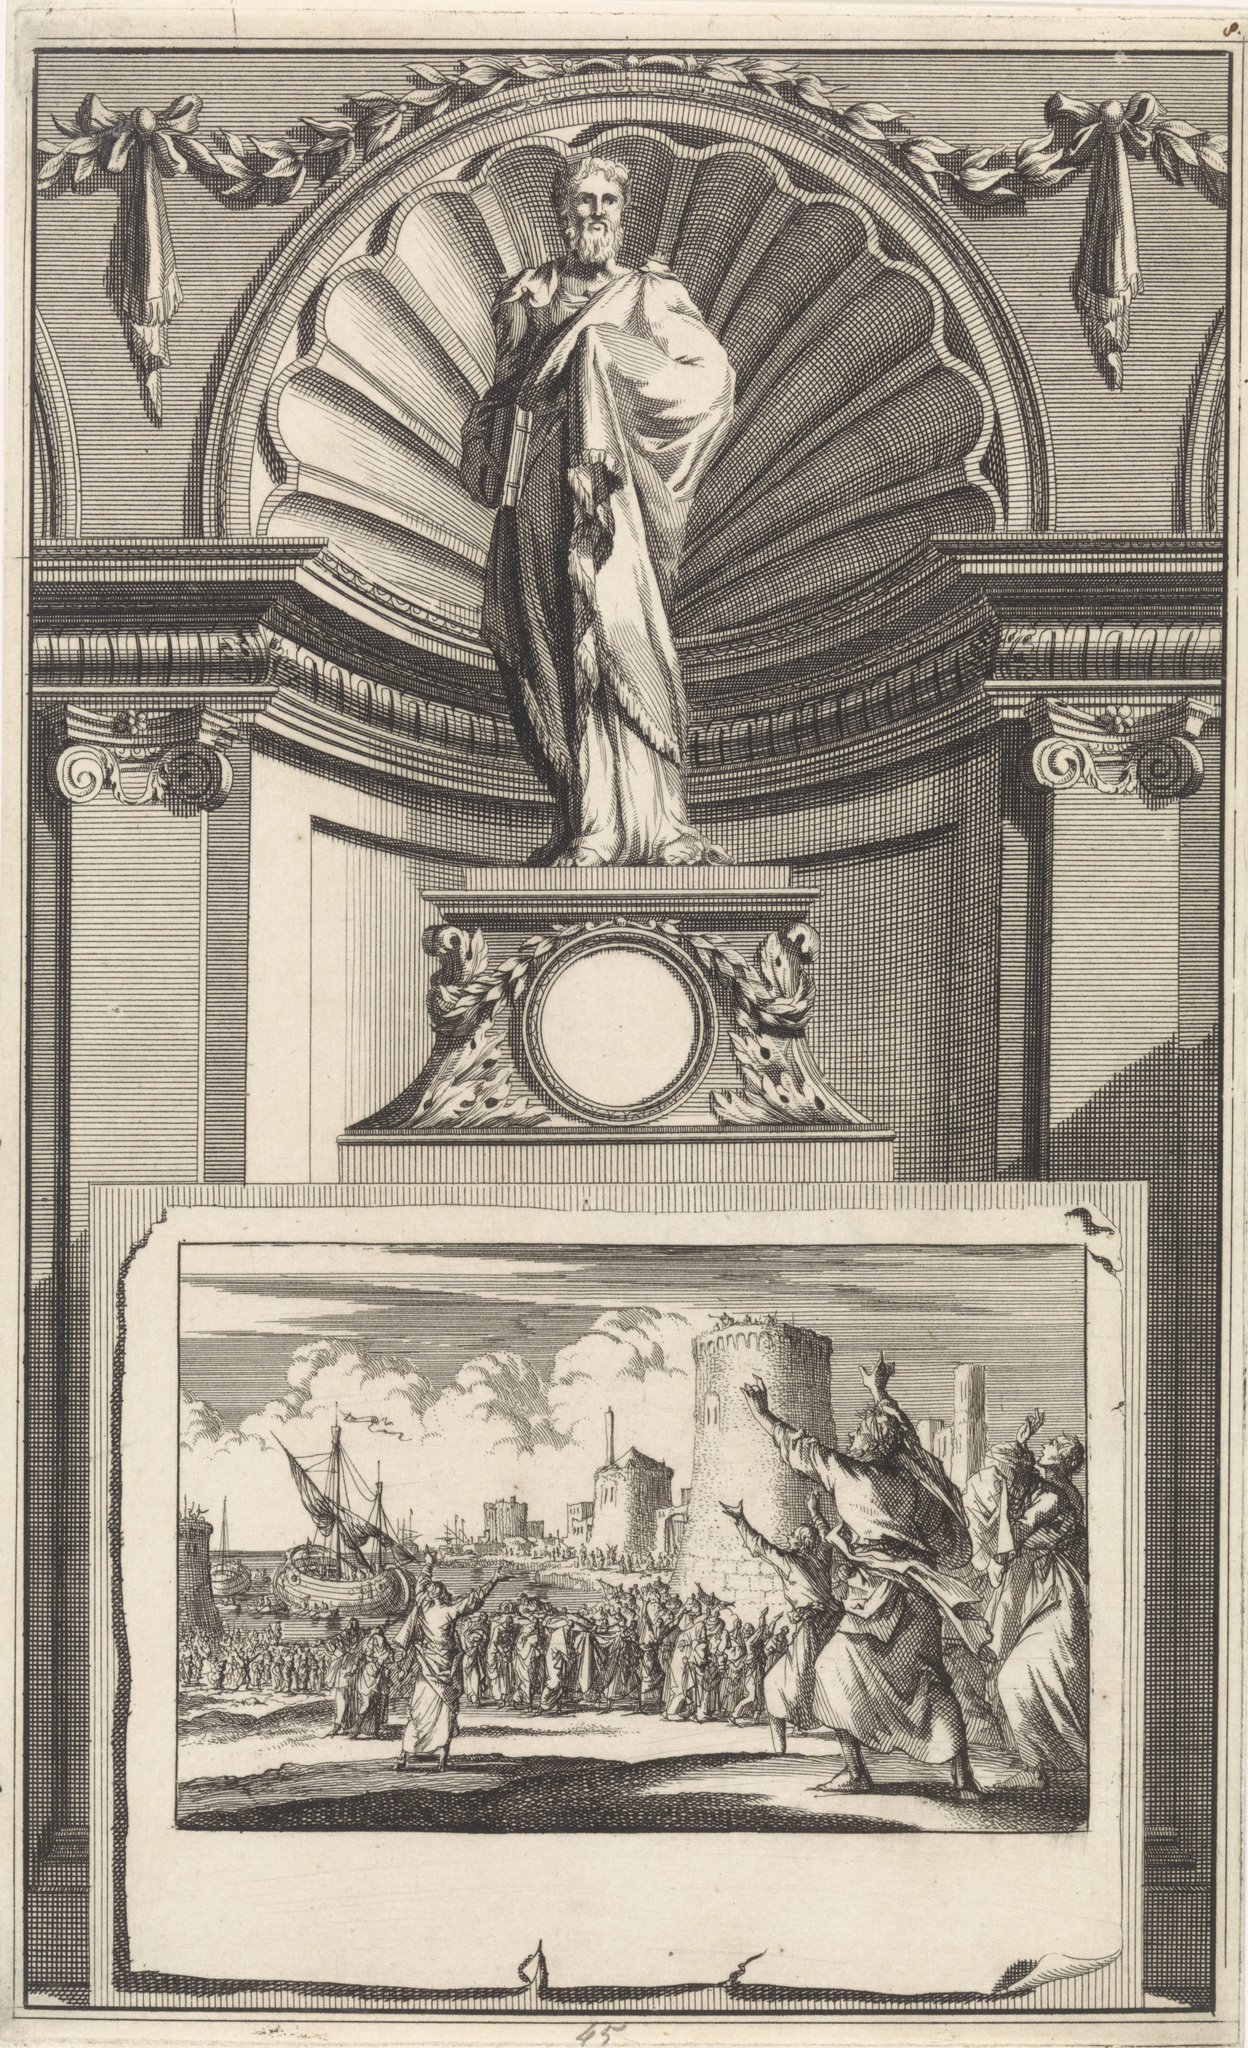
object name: print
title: H. Epiphanius van Salamis, kerkvader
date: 1698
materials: paper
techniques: engraving, etching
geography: amsterdam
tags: male saints (epiphanius of salamis) - martyrdom, suffering, misfortune, death of male saint, male saints (epiphanius of salamis)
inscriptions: collector's mark: Lugt 2228, number: ‘8’, number: ‘45’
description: Proefdruk van illustratie uit: Cave, William. Apostolische oudheden, of Het leven (...) der heylige apostelen, 3 delen. Utrecht: François Halma en Willem van de Water (I), 1698, p. 531.